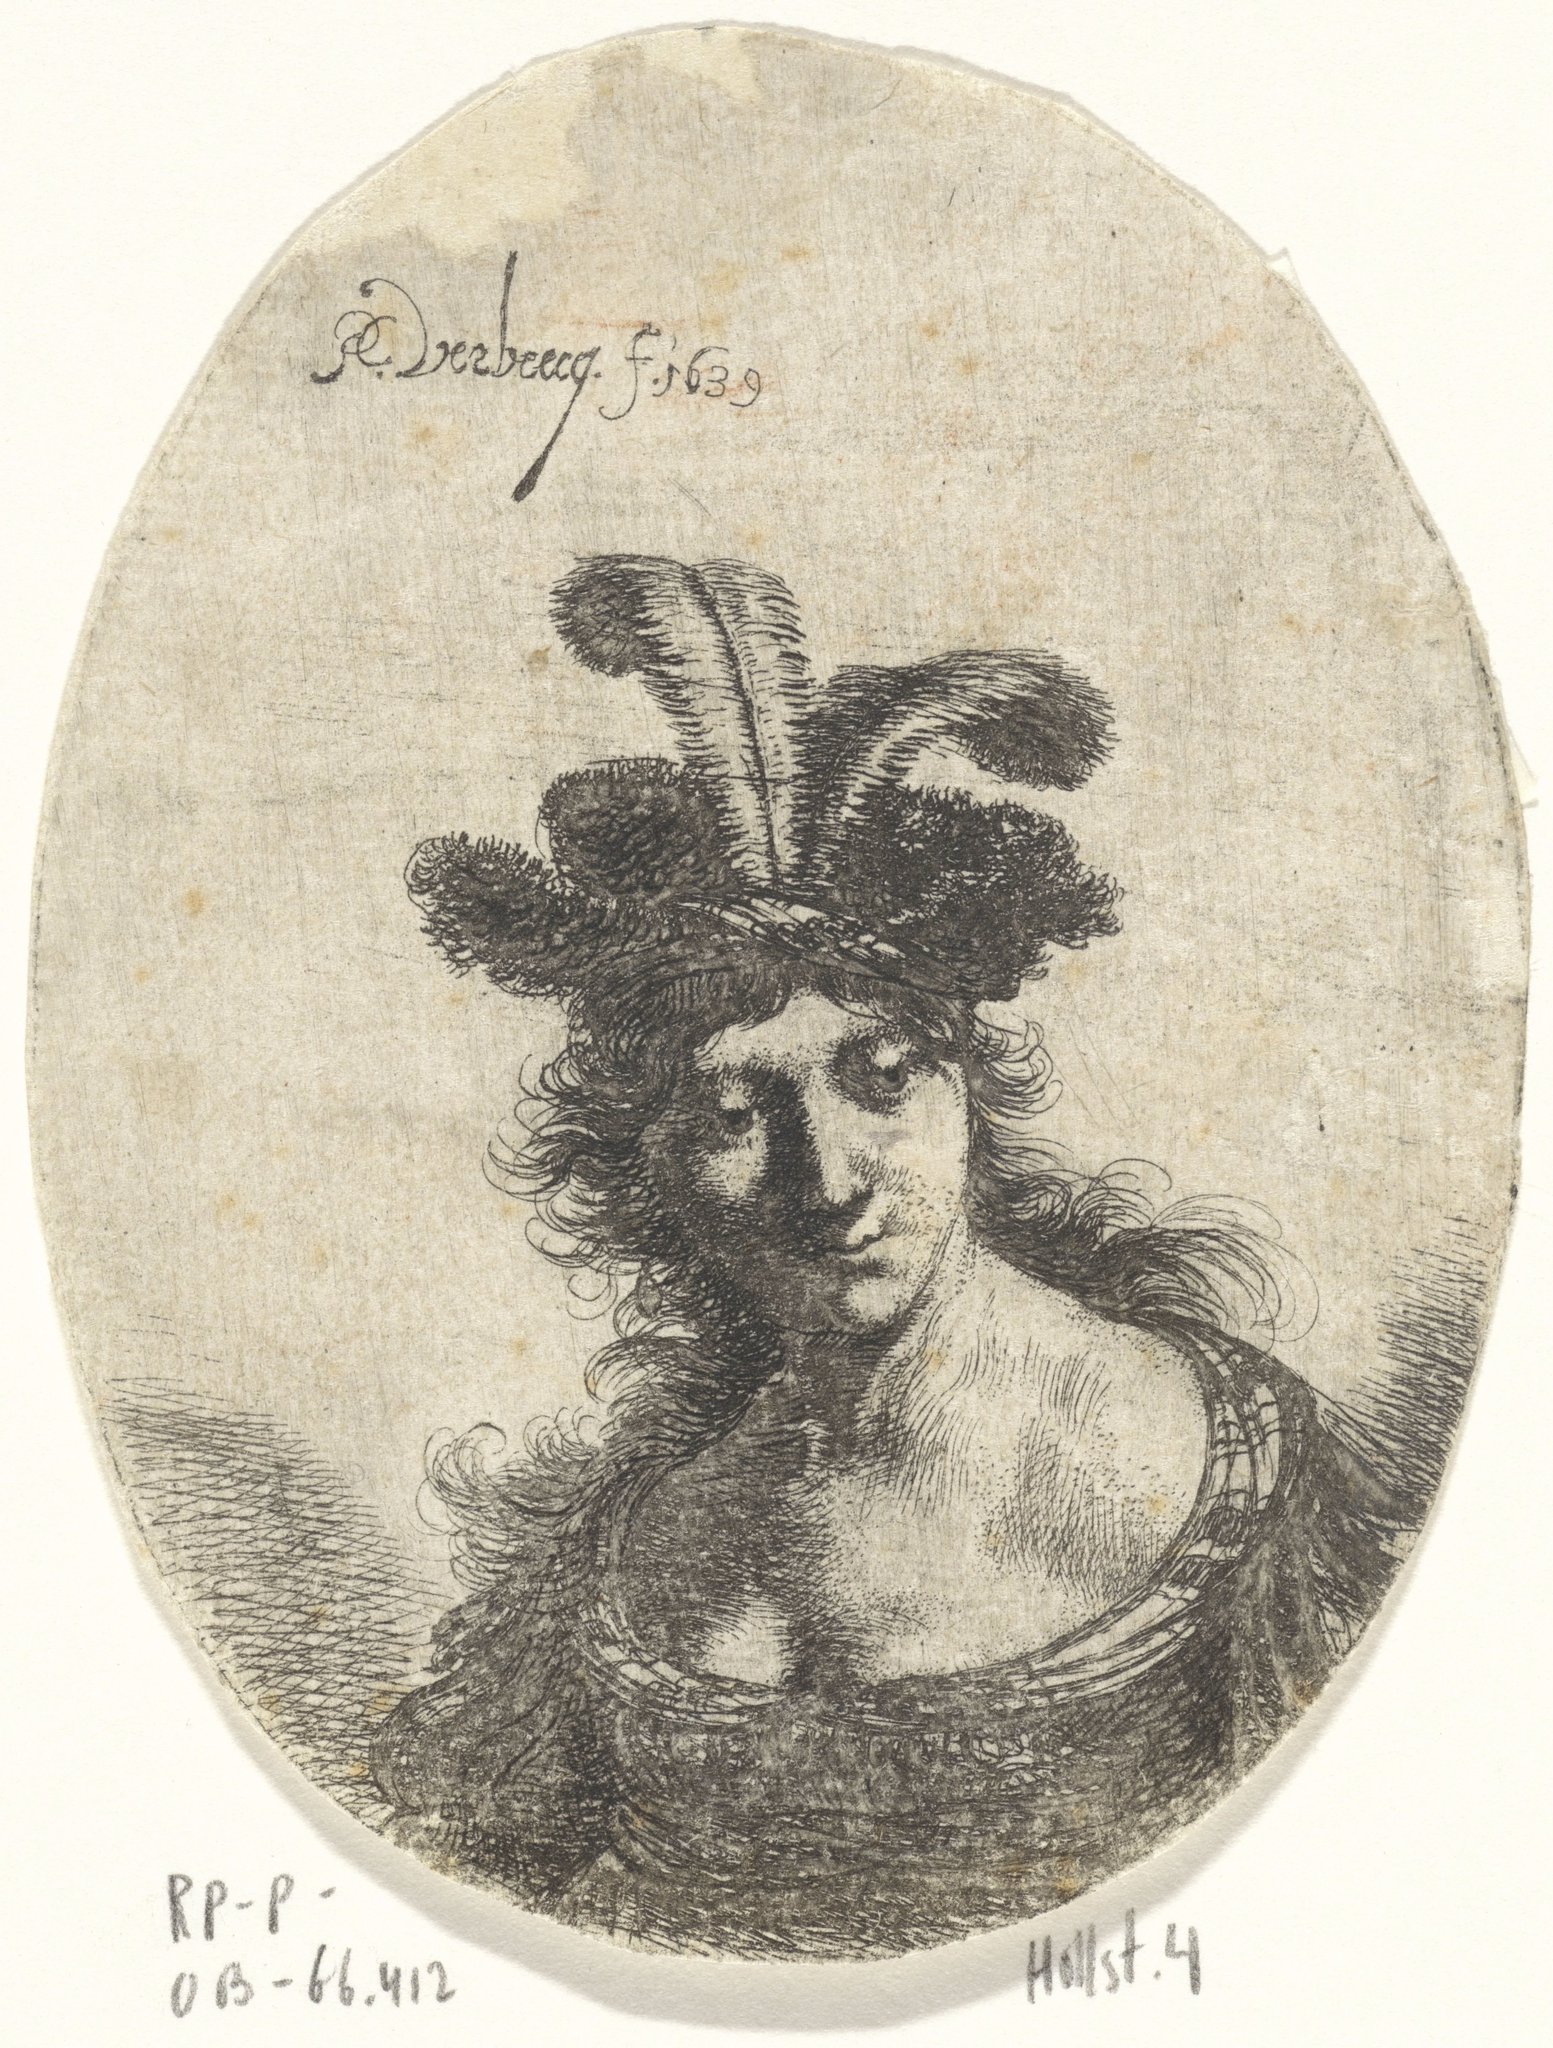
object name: print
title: Jonge vrouw met hoed met veer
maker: pieter cornelisz. verbeeck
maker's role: draughtsman, print maker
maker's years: 1610-1654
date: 1639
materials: paper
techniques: etching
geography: haarlem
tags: adolescent, young woman, maiden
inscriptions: collector's mark: Lugt 2228